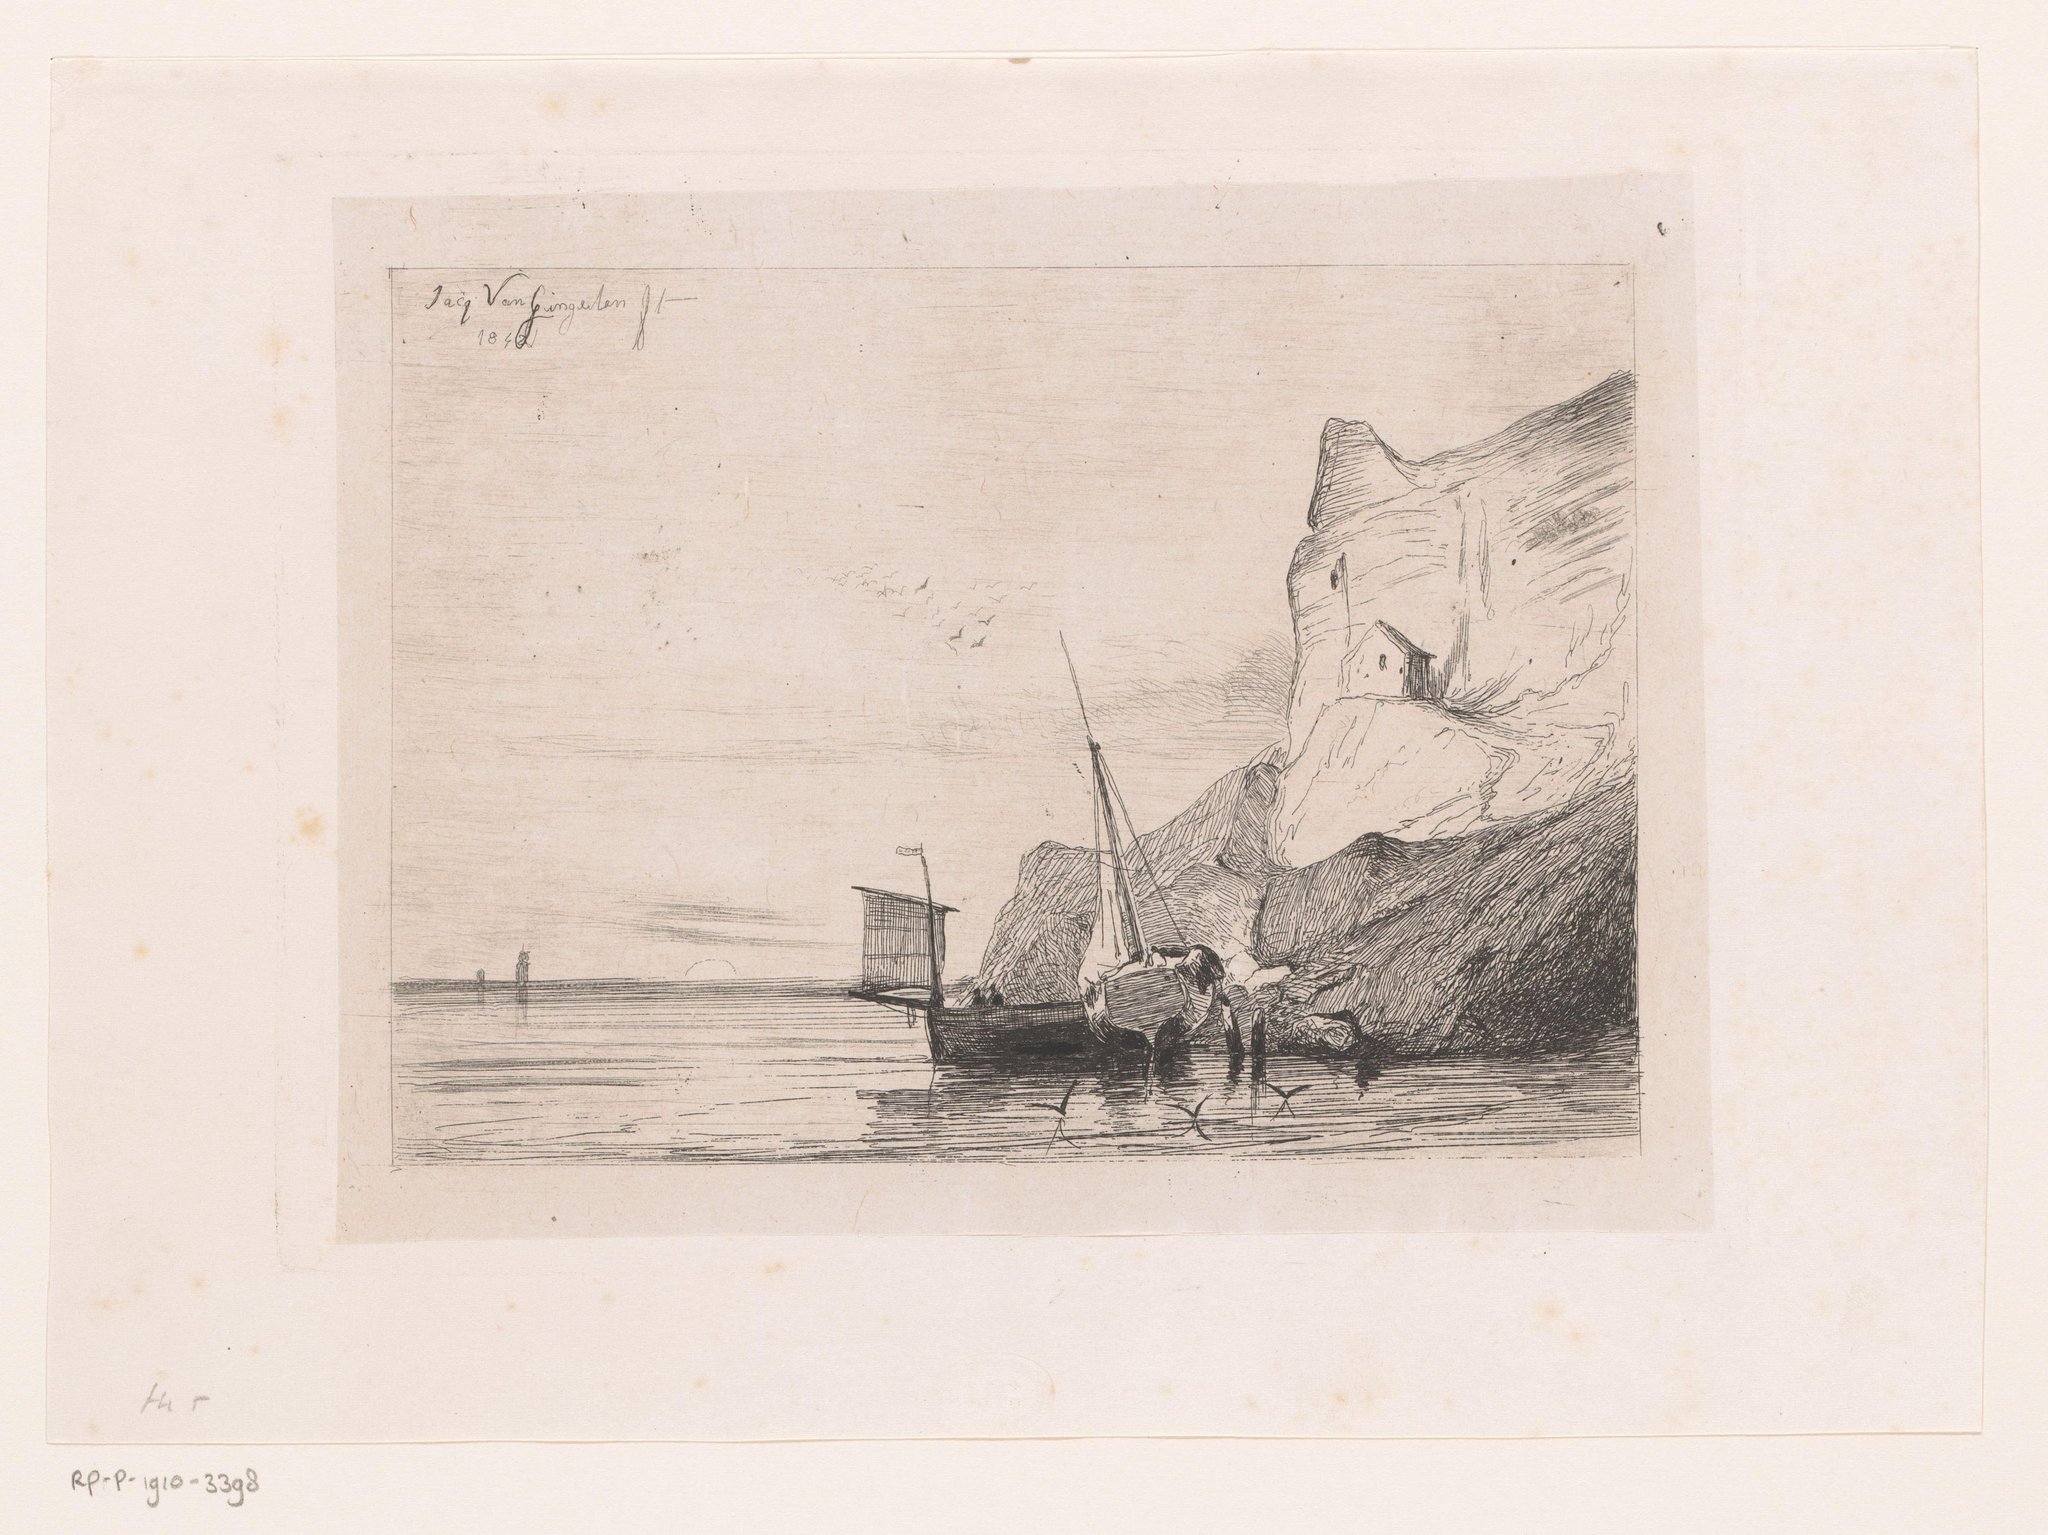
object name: print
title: Kustlandschap met hoge rotsen en schepen in het water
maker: jacques van gingelen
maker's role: print maker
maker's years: 1801-1864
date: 1842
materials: paper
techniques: etching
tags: sailing-ship, sailing-boat, sunset, coastal cliff or crag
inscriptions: mark: ‘JVG’, collector's mark: Lugt 2228